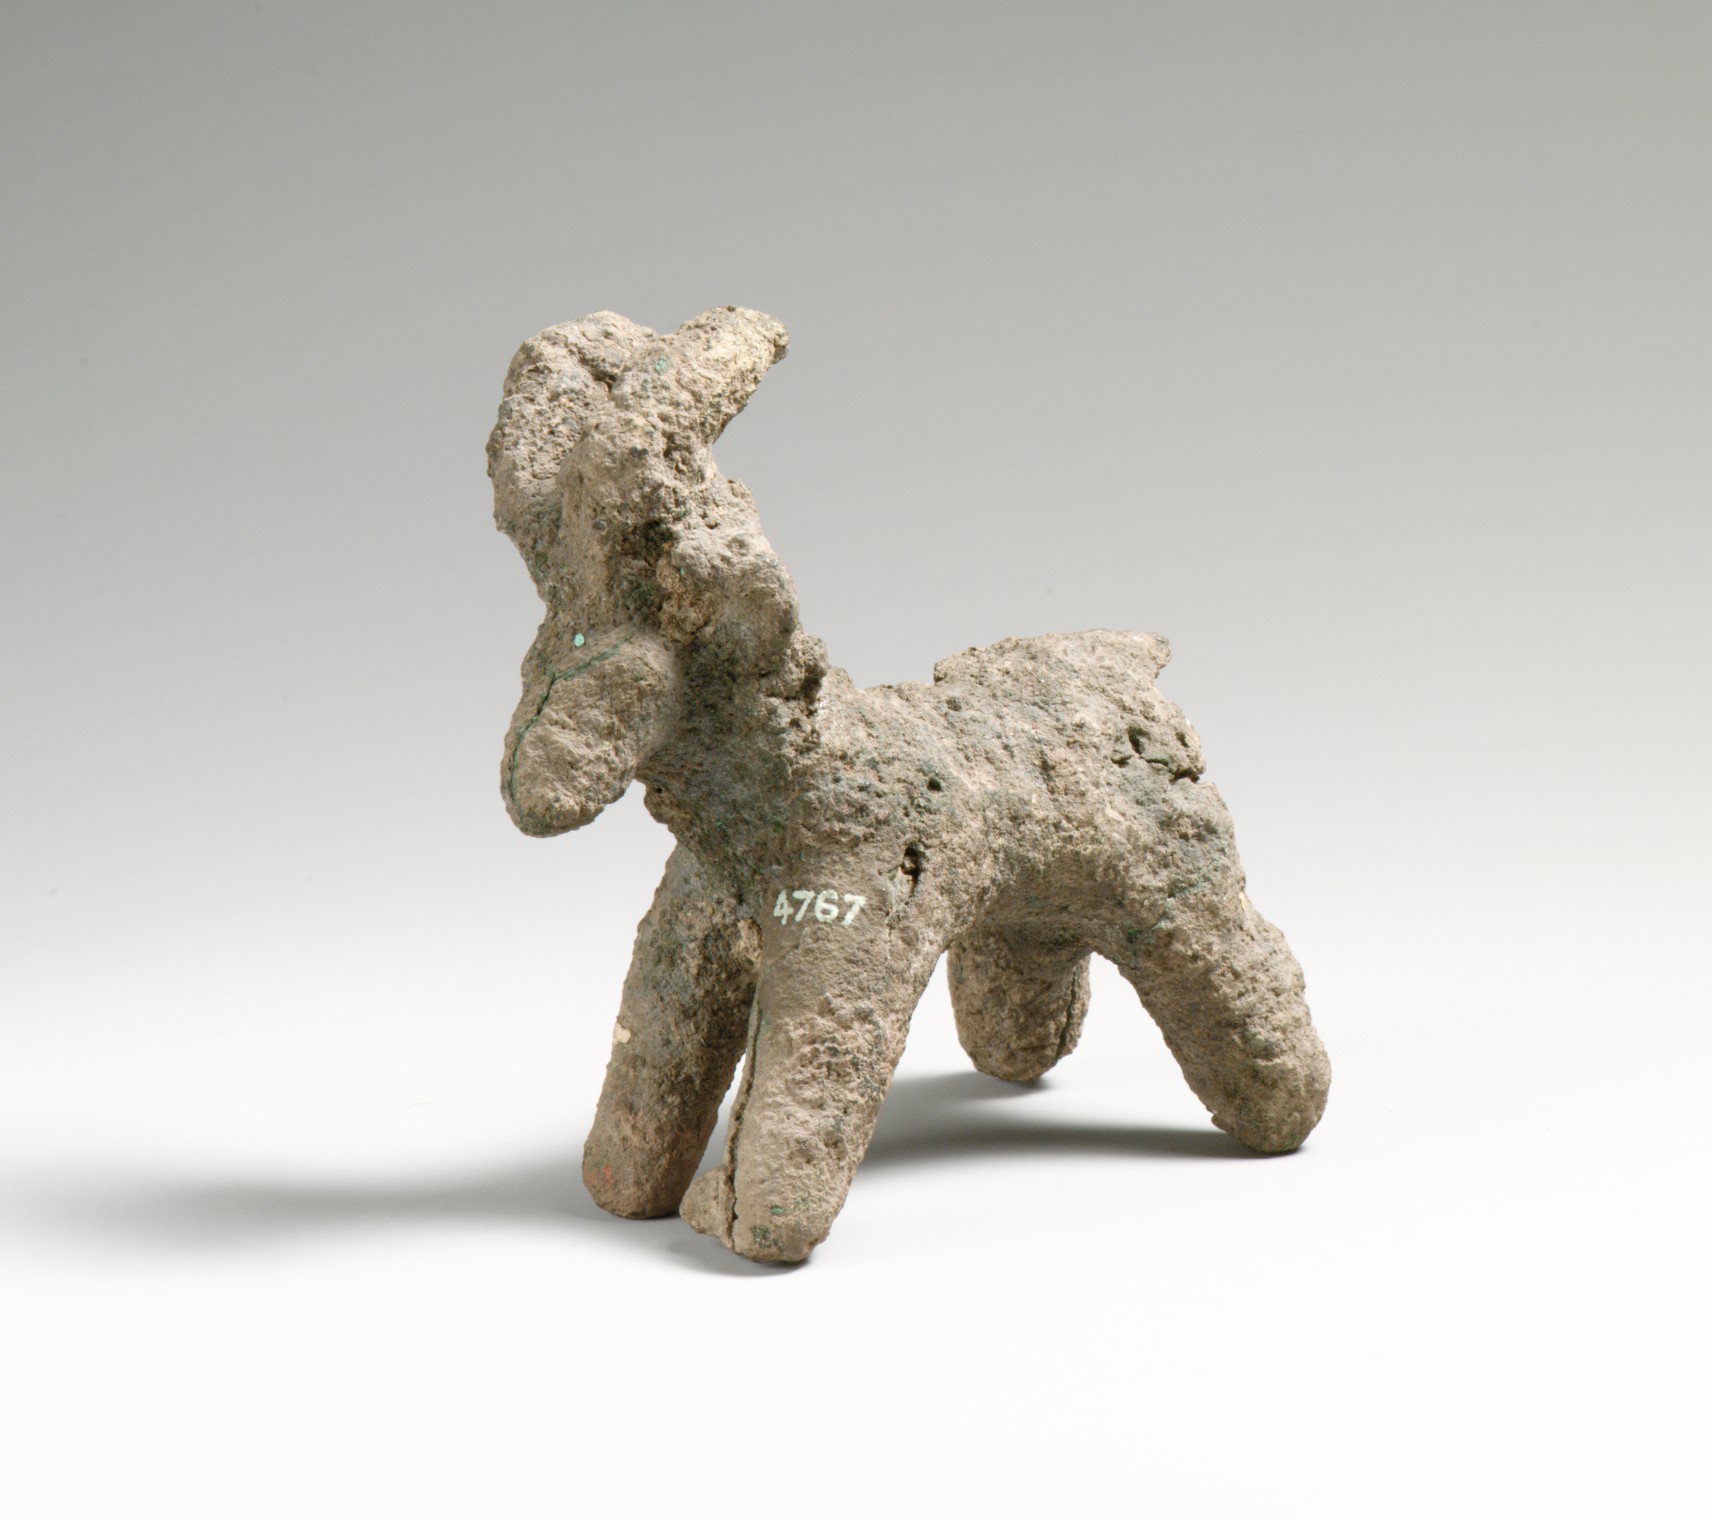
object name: statuette of a goat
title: Bronze statuette of a goat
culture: cypriot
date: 900-701 BCE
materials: bronze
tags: goats